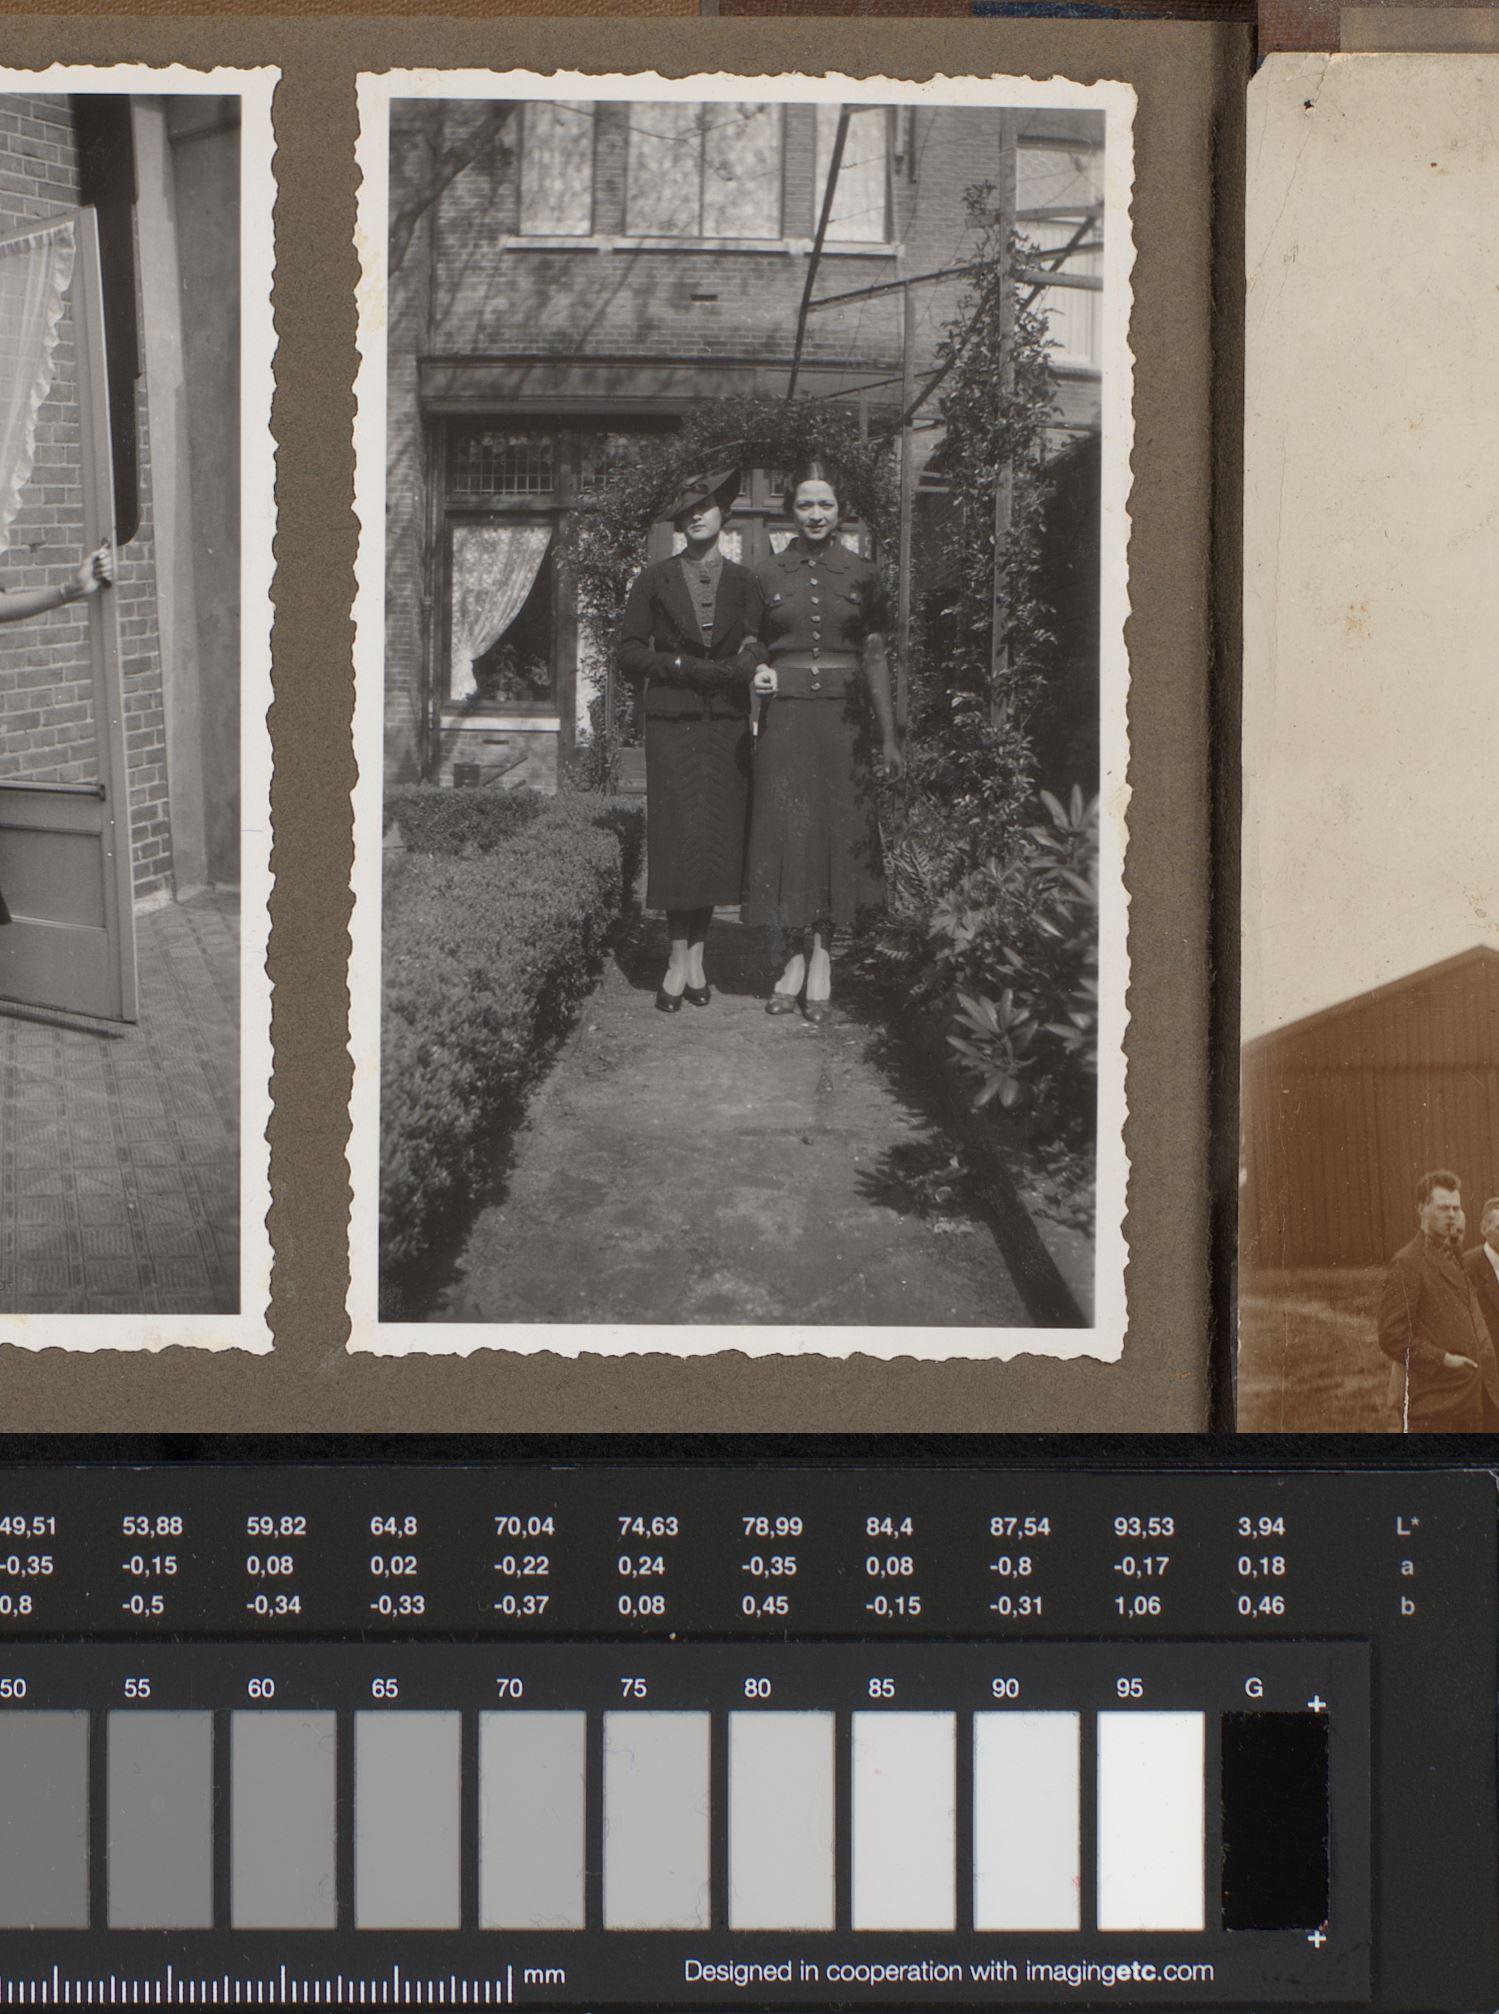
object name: photograph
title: Portret van Dootje en Wilhelmina van Zijll de Jong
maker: Anonymous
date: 1934-1935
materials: paper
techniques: gelatin silver print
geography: netherlands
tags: amsterdam, the hague, wilhelmina van zijll de jong, historical persons - bb - woman, sisters (second degree family relationships), netherlands